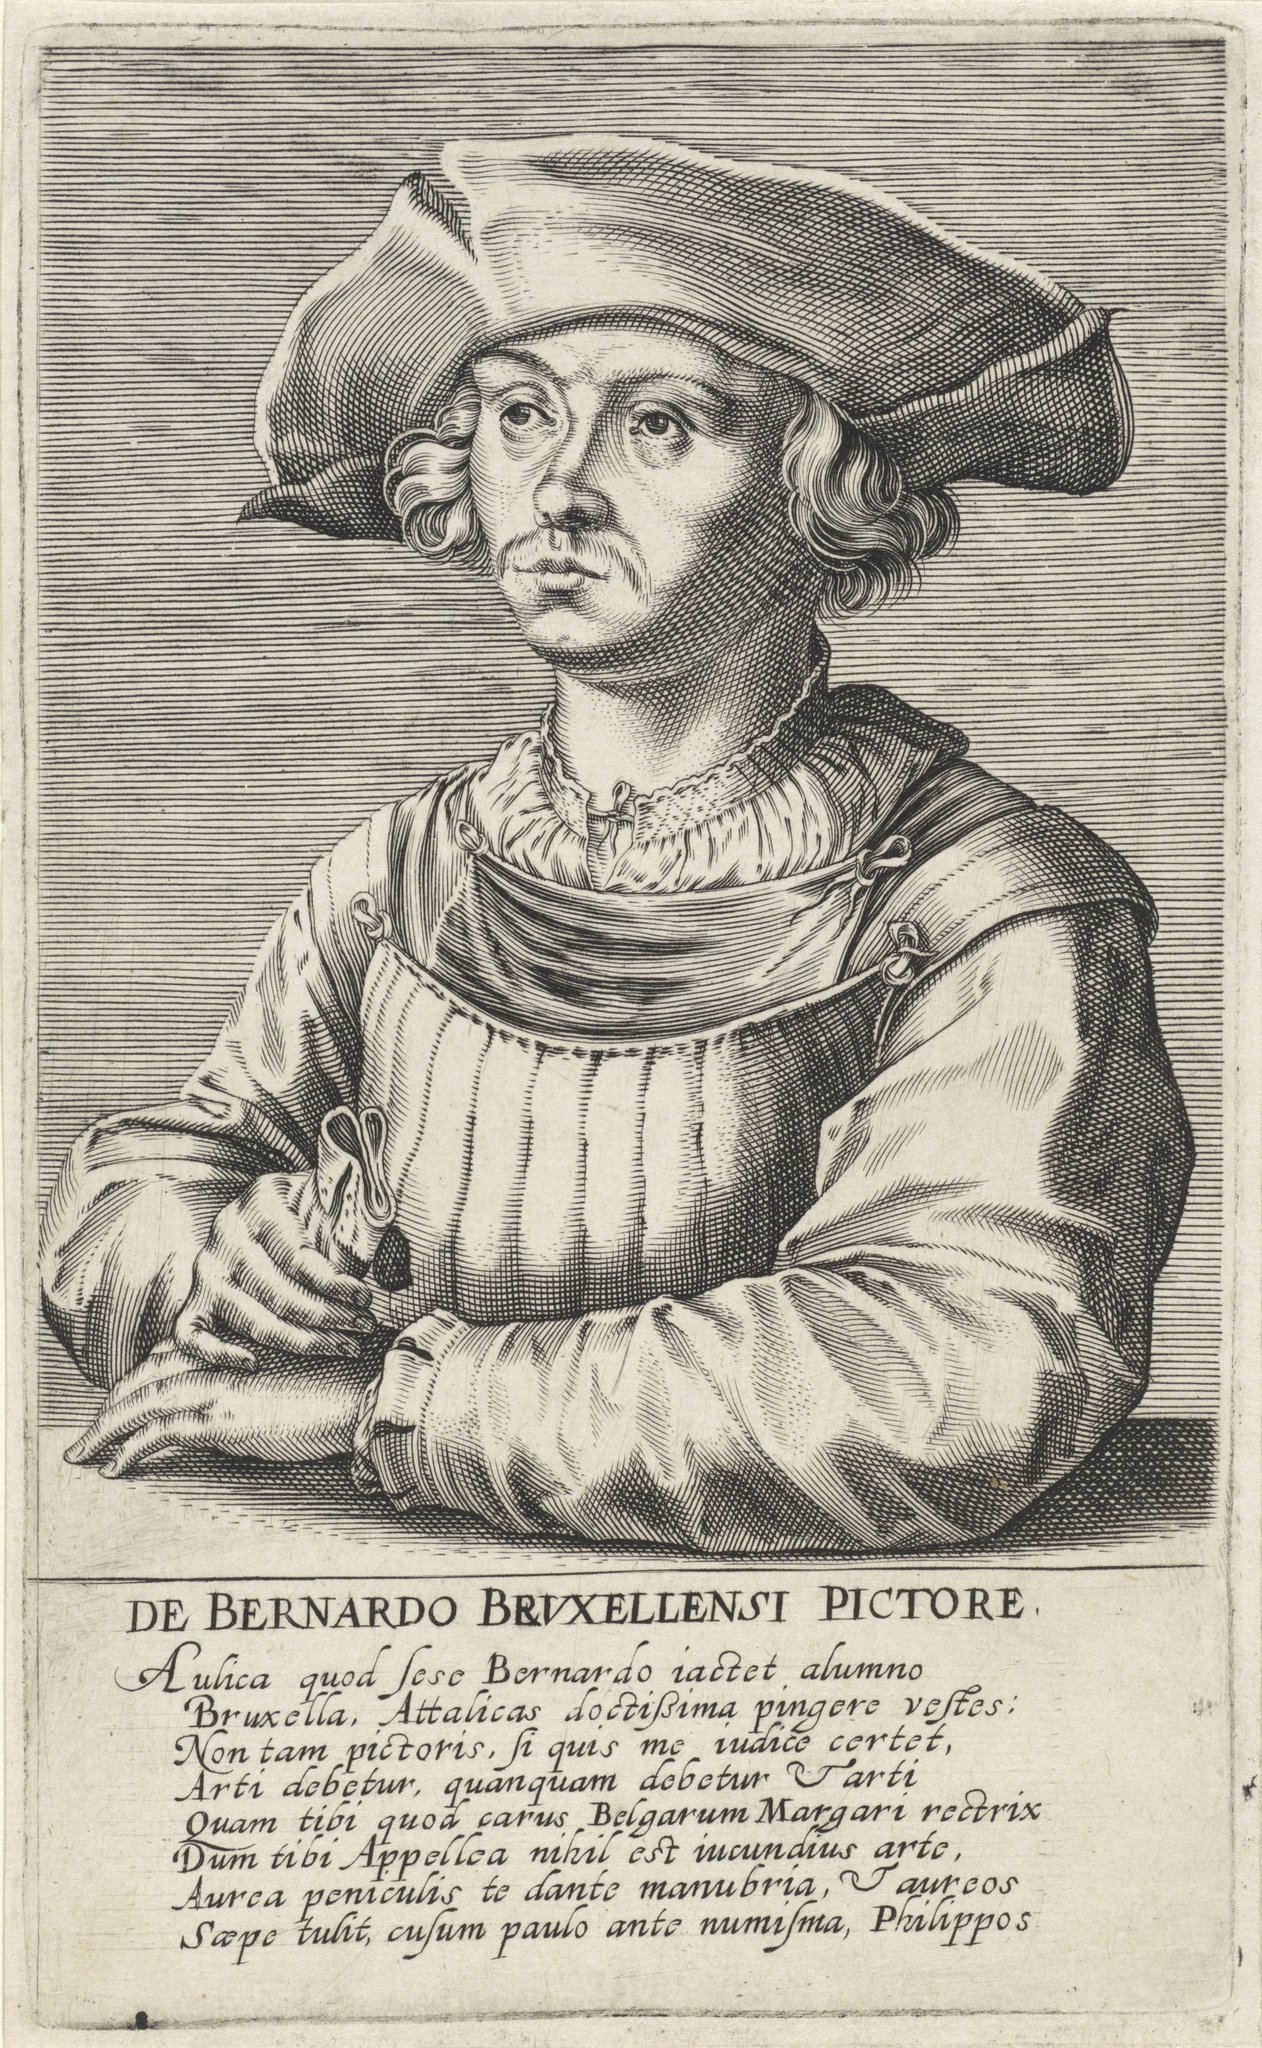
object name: print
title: Portret van Bernard van Orley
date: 1610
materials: paper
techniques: engraving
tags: brussels, painter, draughtsman, bernard van orley, portrait, self-portrait of painter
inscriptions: collector's mark: Lugt 2228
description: In de marge een achtregelig onderschrift in het Latijn.